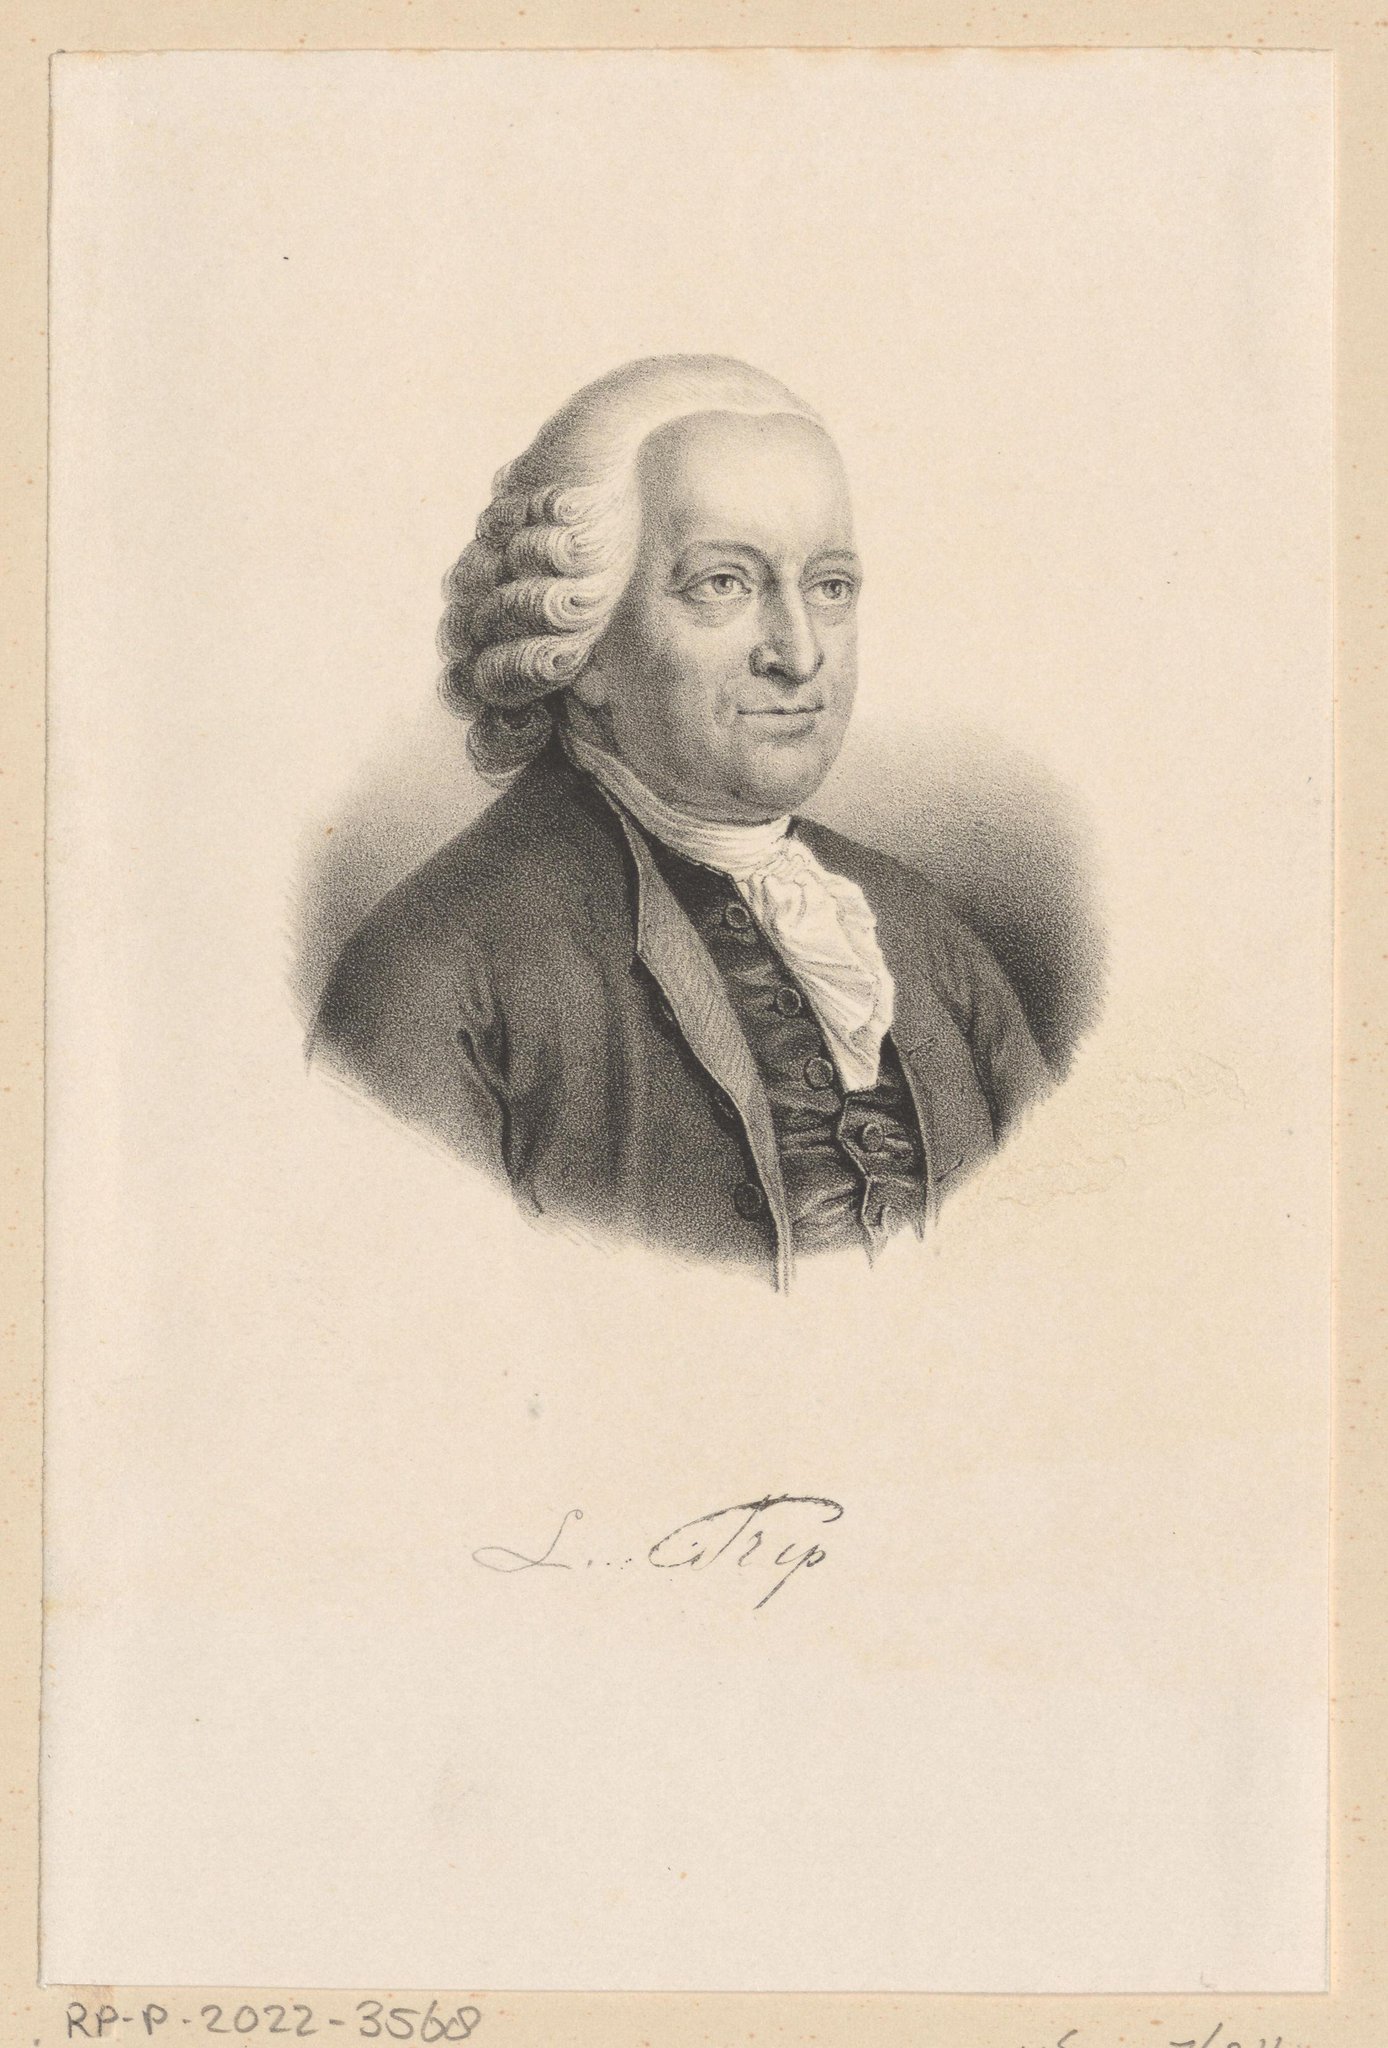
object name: print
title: Portret van Lucas Trip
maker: Anonymous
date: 1846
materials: paper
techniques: lithograph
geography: netherlands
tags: lucas trip, historical persons, portrait of a writer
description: Prent waarschijnlijk uit: Gronings Volksalmanak (1846).